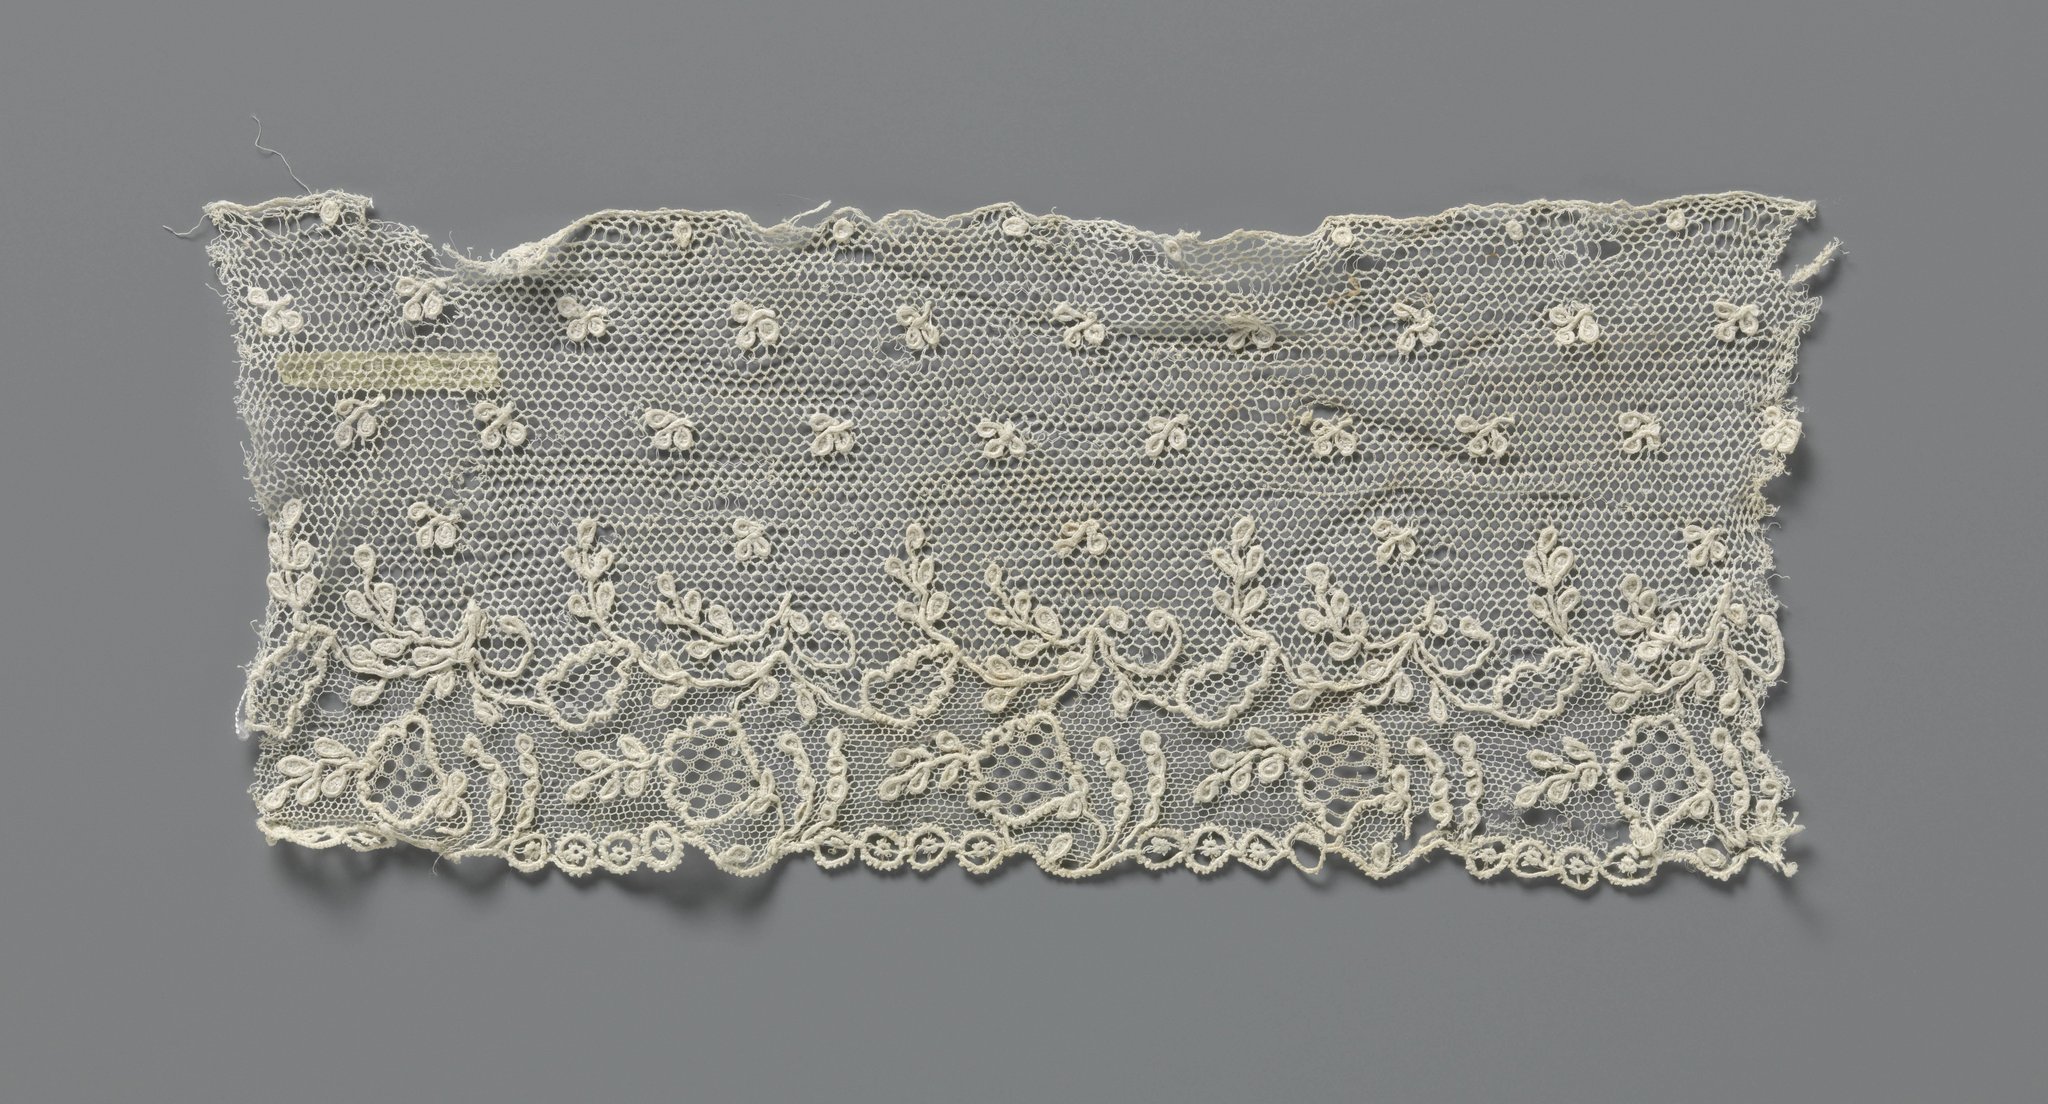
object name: strip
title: Strook naaldkant met klaverblaadjes en waaiervormige bloemen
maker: Anonymous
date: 1775-1799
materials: linen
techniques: lace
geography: alençon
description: Strook naturelkleurige naaldkant: heren-Alençon. Strooimotief met klaverblaadjes op een fijne zeshoekige maasgrond. Langs de bovenrand een rij moesjes. Het patroon aan de onderzijde van de strook bestaat uit een aaneenschakeling van bladertakken met pluimen. Daaronder waaiervormige bloemen die vanuit de onderrand ontspringen, gevuld met een siergrond. De onderzijde is afgewerkt met geschulpte rand van gepicoteerde cirkeltjes met daarin een raderpicot. De bovenzijde is afgewerkt met een rechte rand.